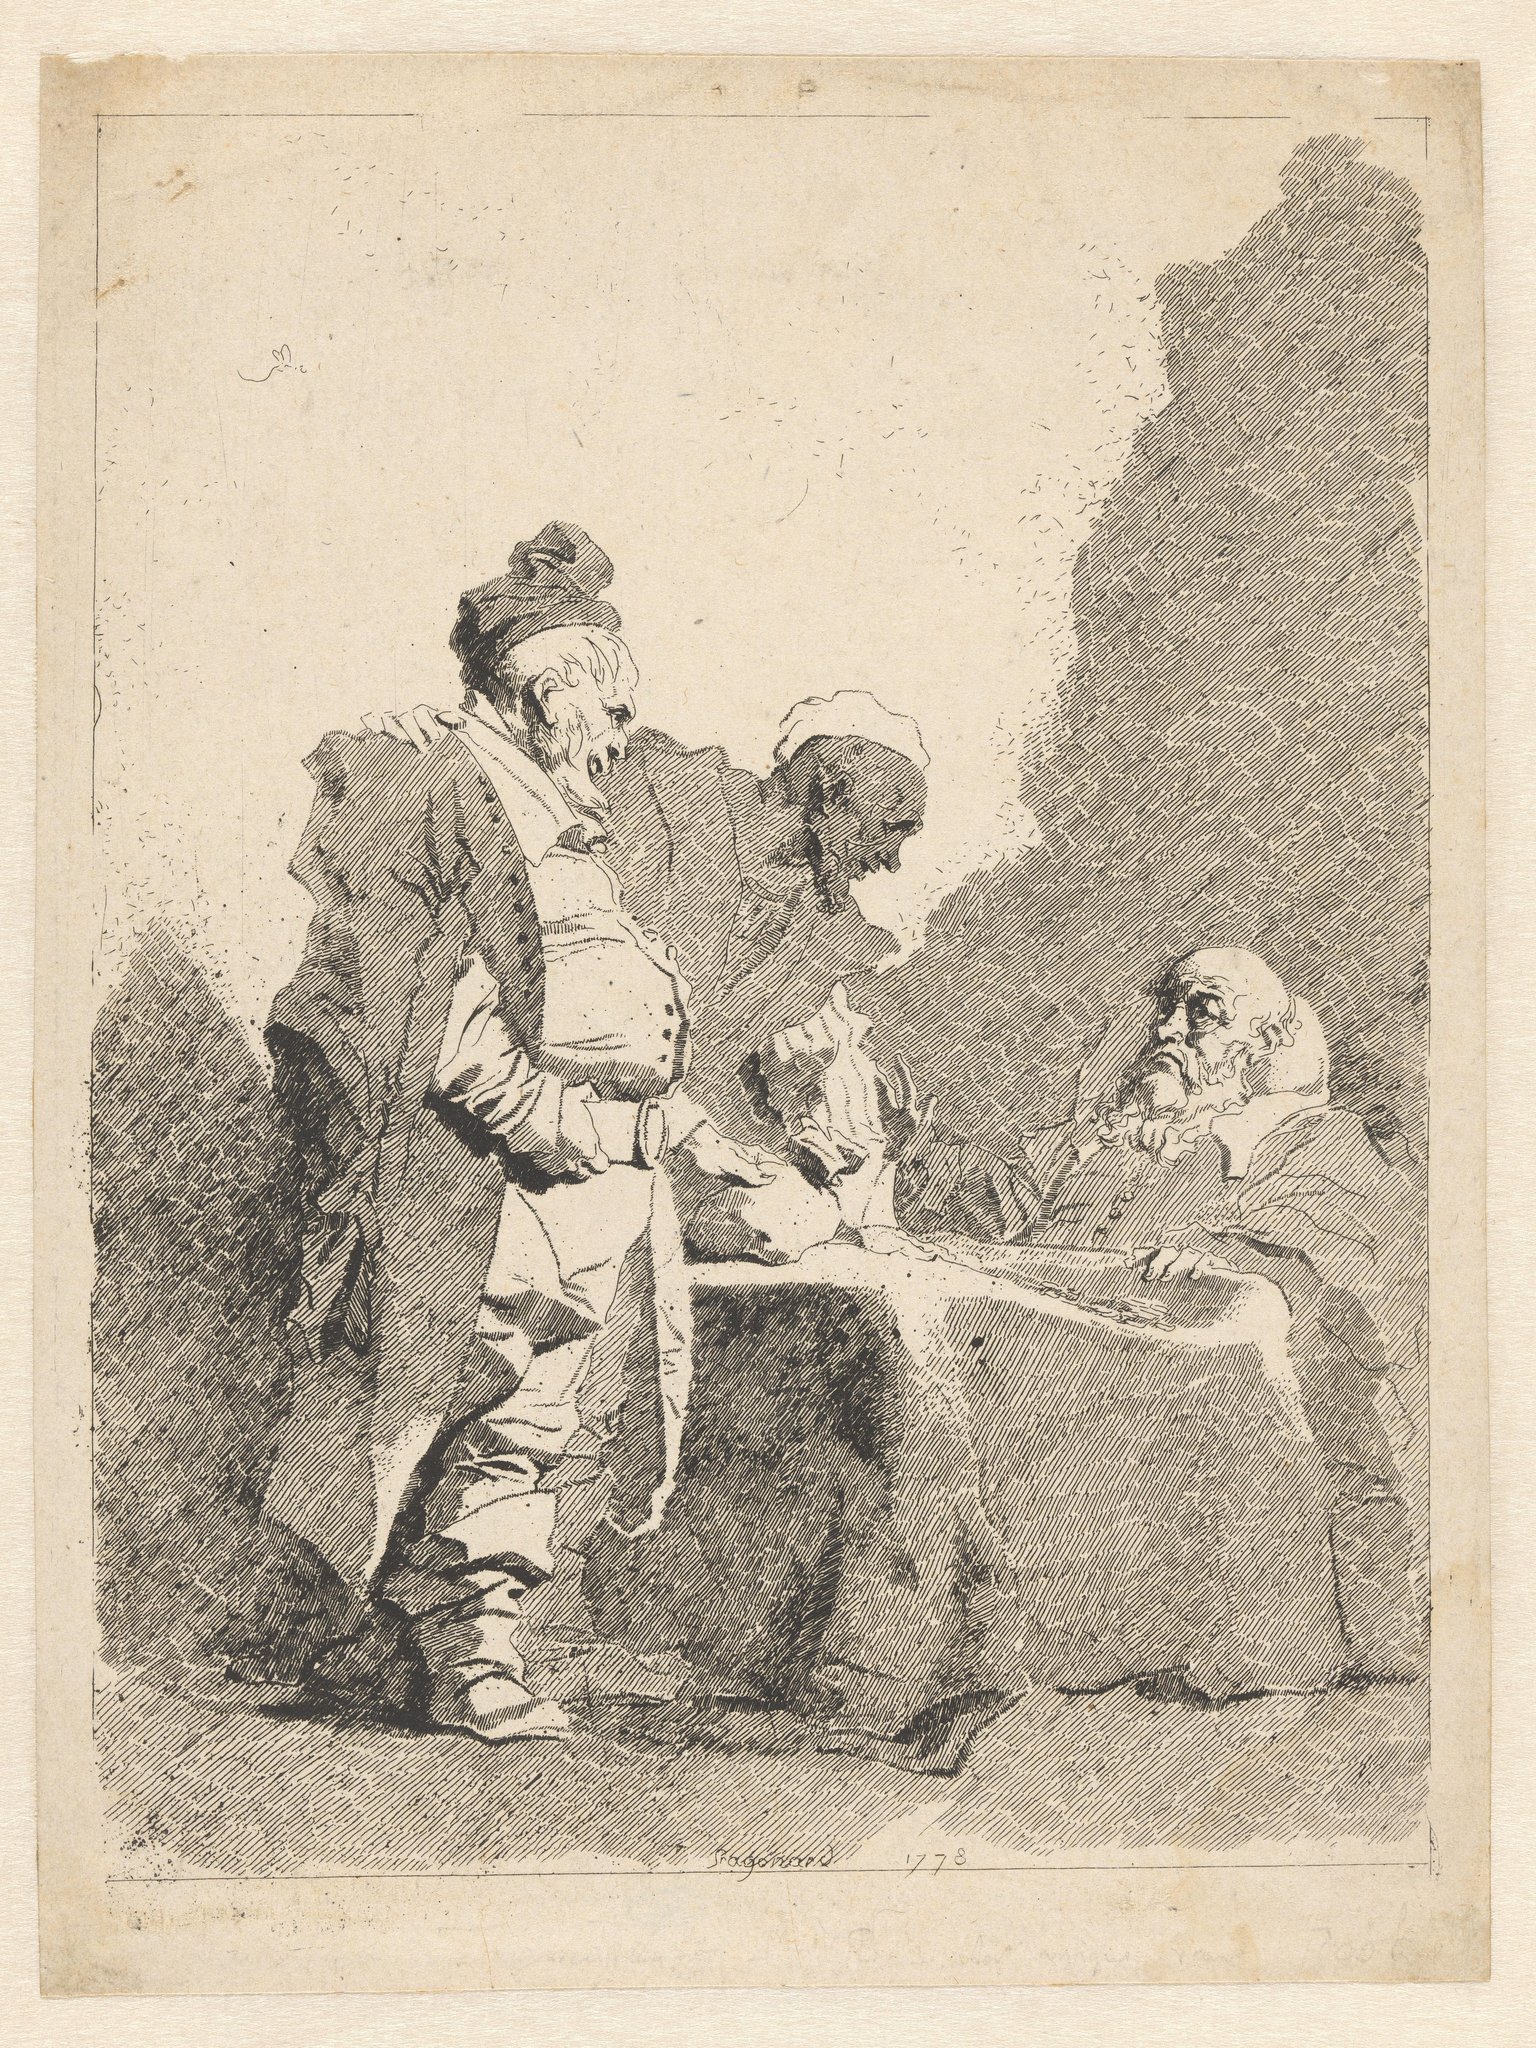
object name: print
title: De belastingontvangers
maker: jean honoré fragonard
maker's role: draughtsman, painter, print maker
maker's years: 1732-1806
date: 1778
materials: paper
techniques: etching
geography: paris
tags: tax collection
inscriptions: collector's mark: Lugt 2228, collector's mark: Lugt 2760, collector's mark: Lugt 5684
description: Twee staande mannen, de belastingontvangers, in gesprek met een man zittend achter een tafel.